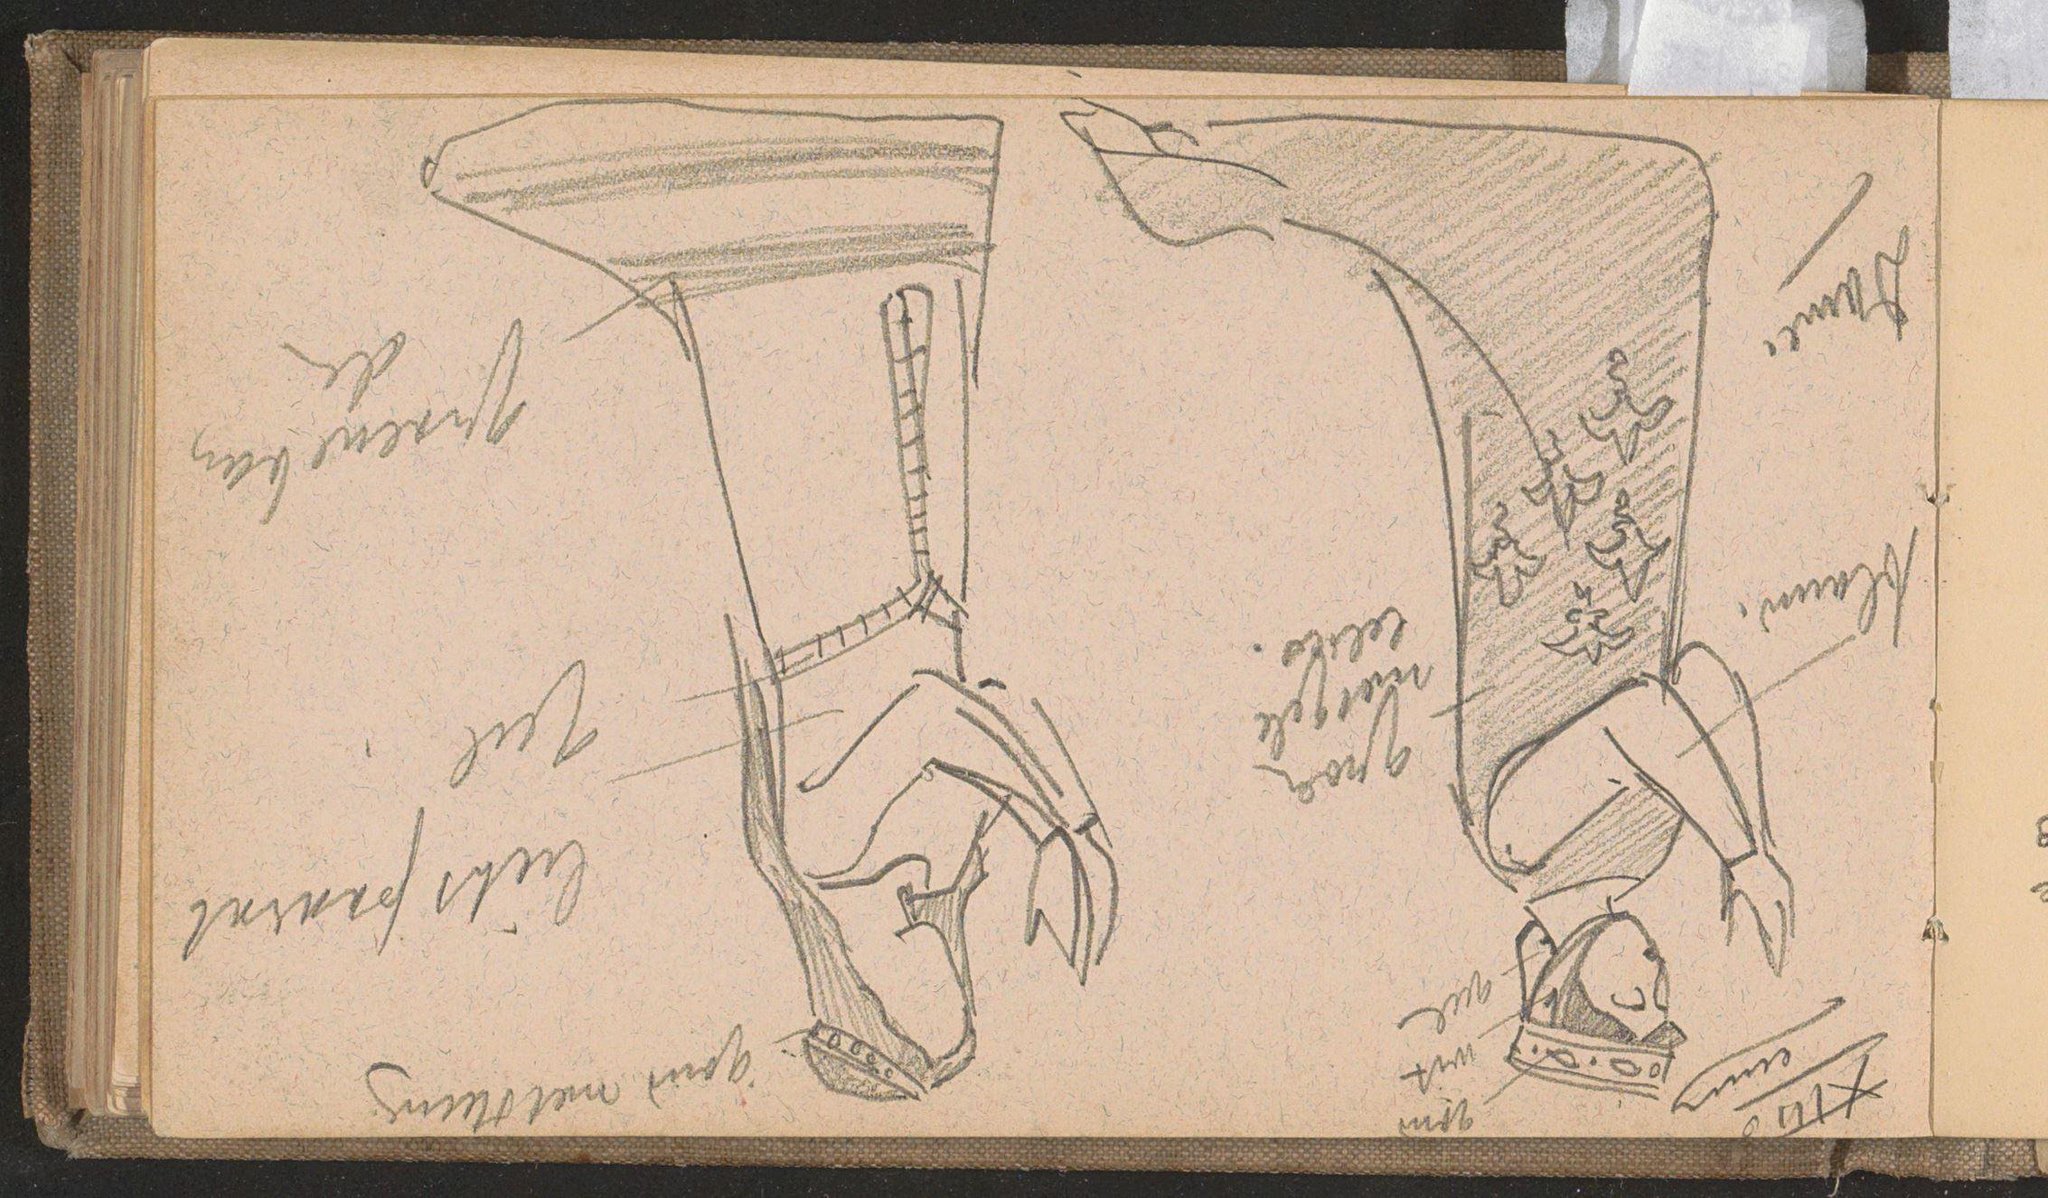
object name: sketchbook leaf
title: Knielende jonkvrouwen in bidhouding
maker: antoon derkinderen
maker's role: draughtsman, painter, print maker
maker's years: 1859-1925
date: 1892-1901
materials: paper, pencil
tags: historical costume, one person praying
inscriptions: annotation: ‘XIIIe/ eeuw’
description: Getekend naar een voorbeeld uit de dertiende eeuw na Christus. Blad 36 verso uit een schetsboek met 51 bladen.